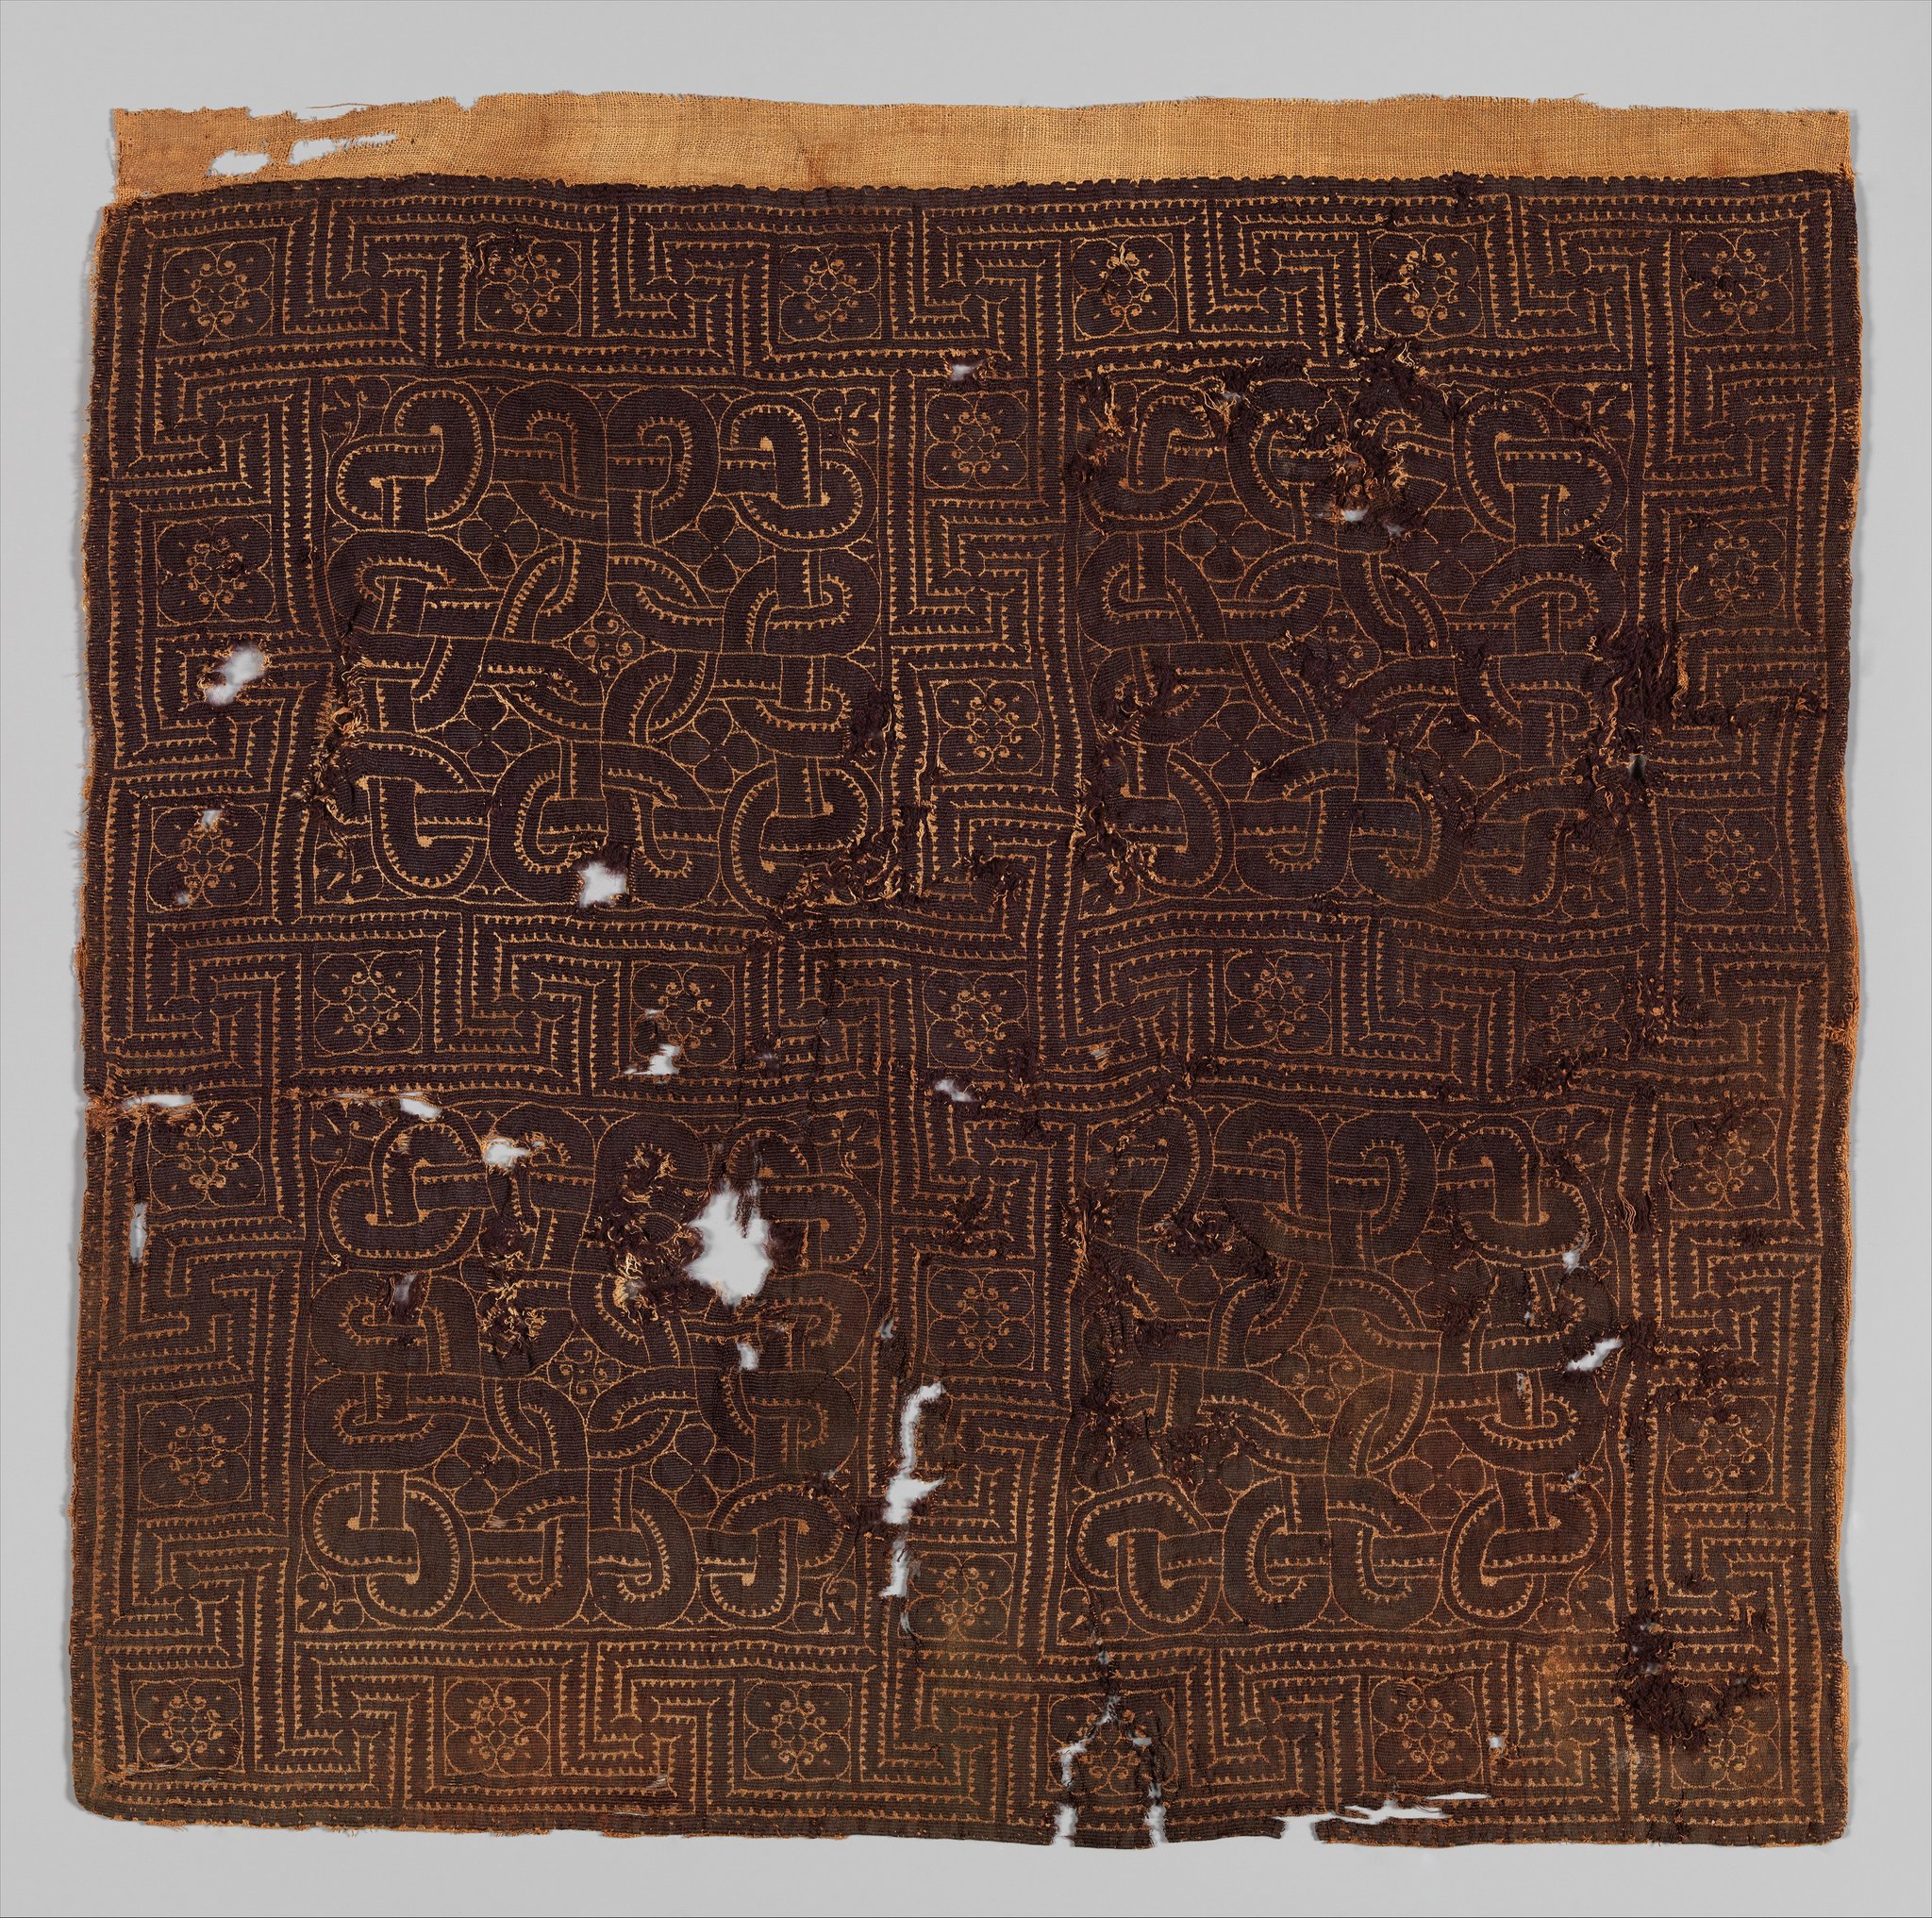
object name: textile fragment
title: Textile Fragment with Interlace Pattern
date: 201-400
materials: linen, wool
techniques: weave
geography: egypt